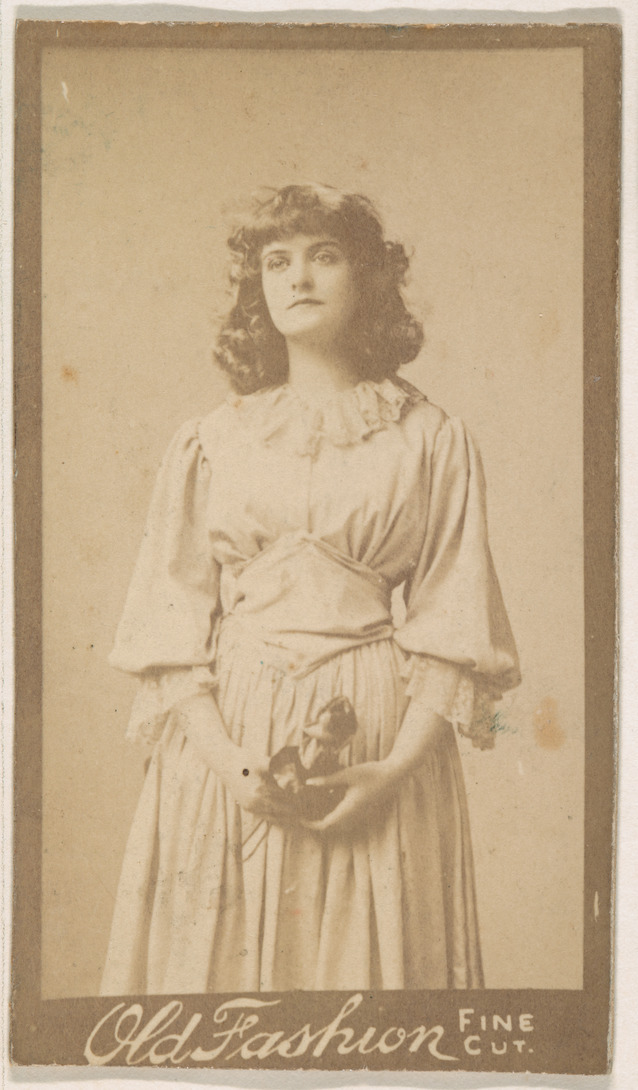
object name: photograph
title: Portrait of actress, from the Actresses series (N664) promoting Old Fashion Fine Cut Tobacco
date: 1888-1890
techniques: albumen silver print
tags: portraits,women,actresses